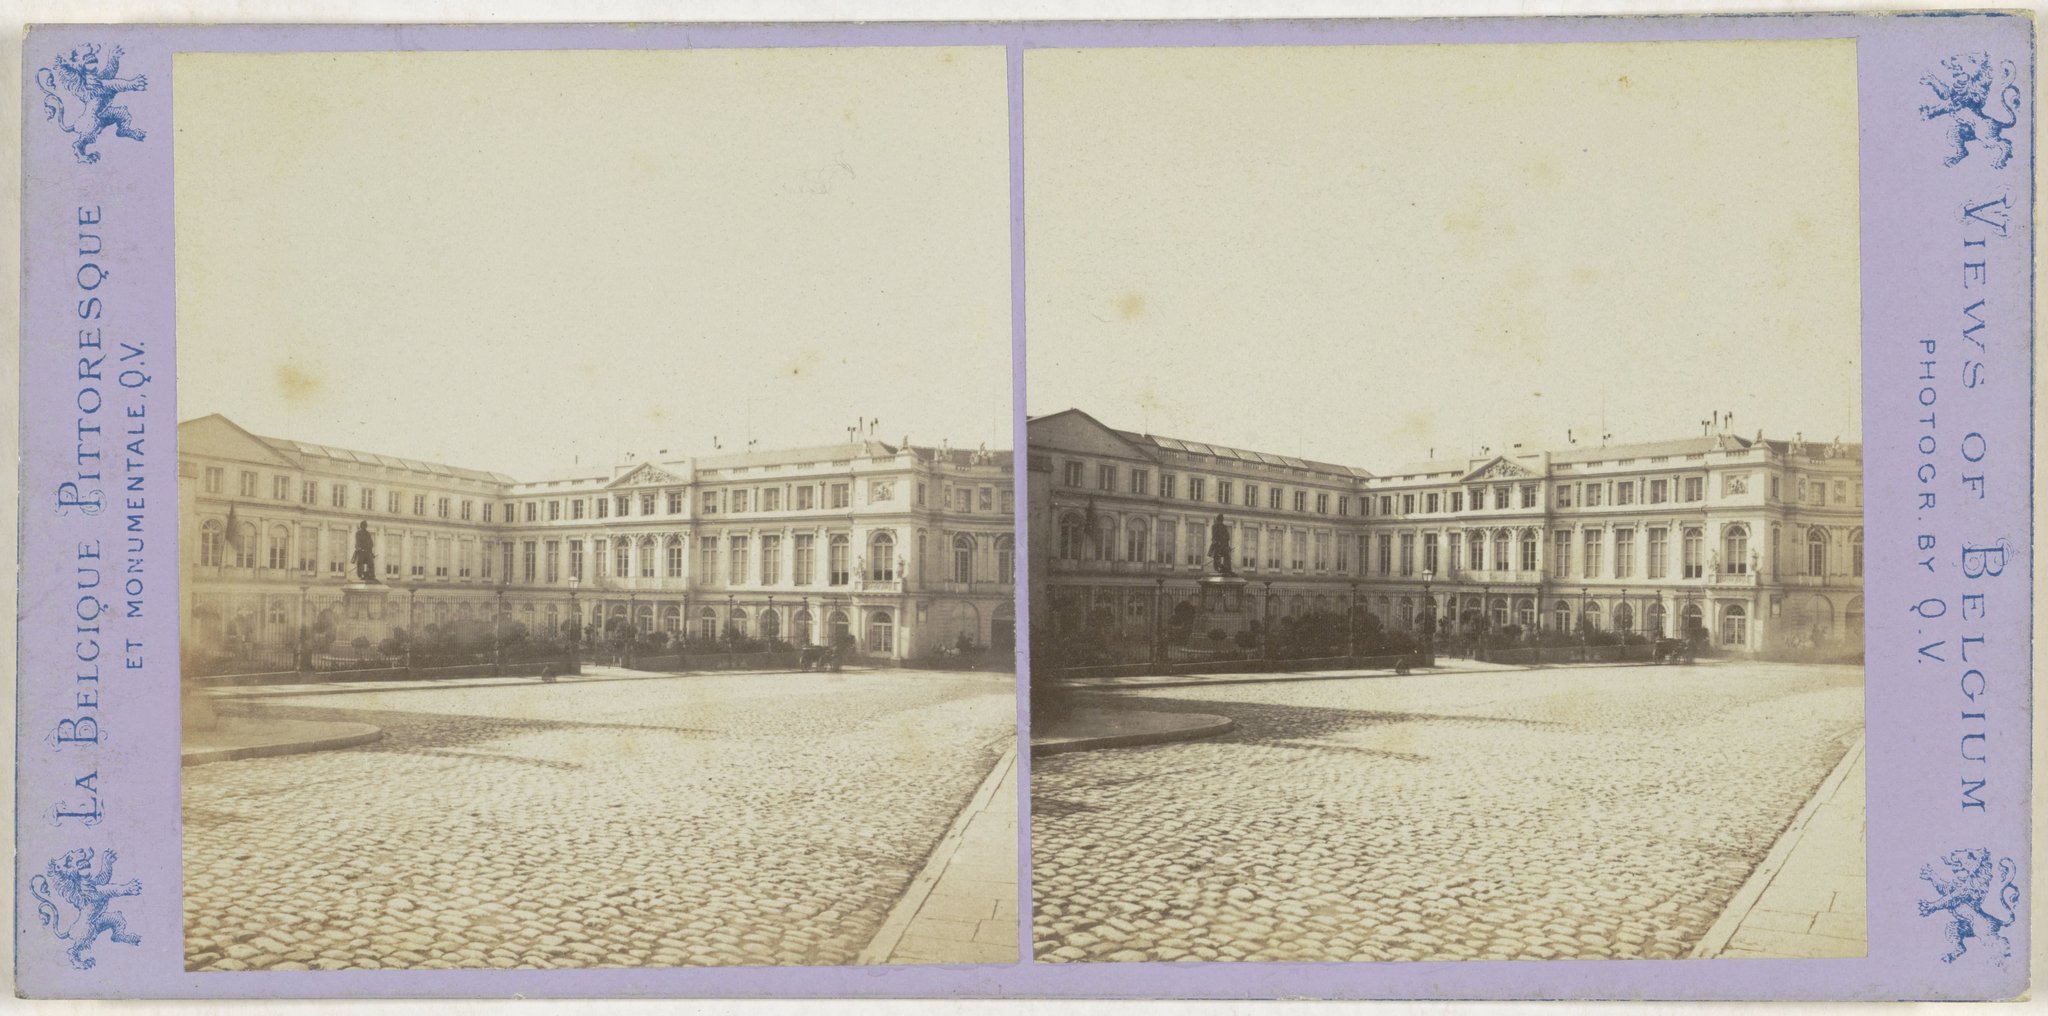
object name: stereograph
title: Bruxelles, le musée et la palais de l'industrie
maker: jules hippolyte quéval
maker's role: publisher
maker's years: 1824-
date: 1866-1870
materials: cardboard, paper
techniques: albumen print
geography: brussels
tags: square, place, circus, etc., palace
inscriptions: number: ‘No 1623’